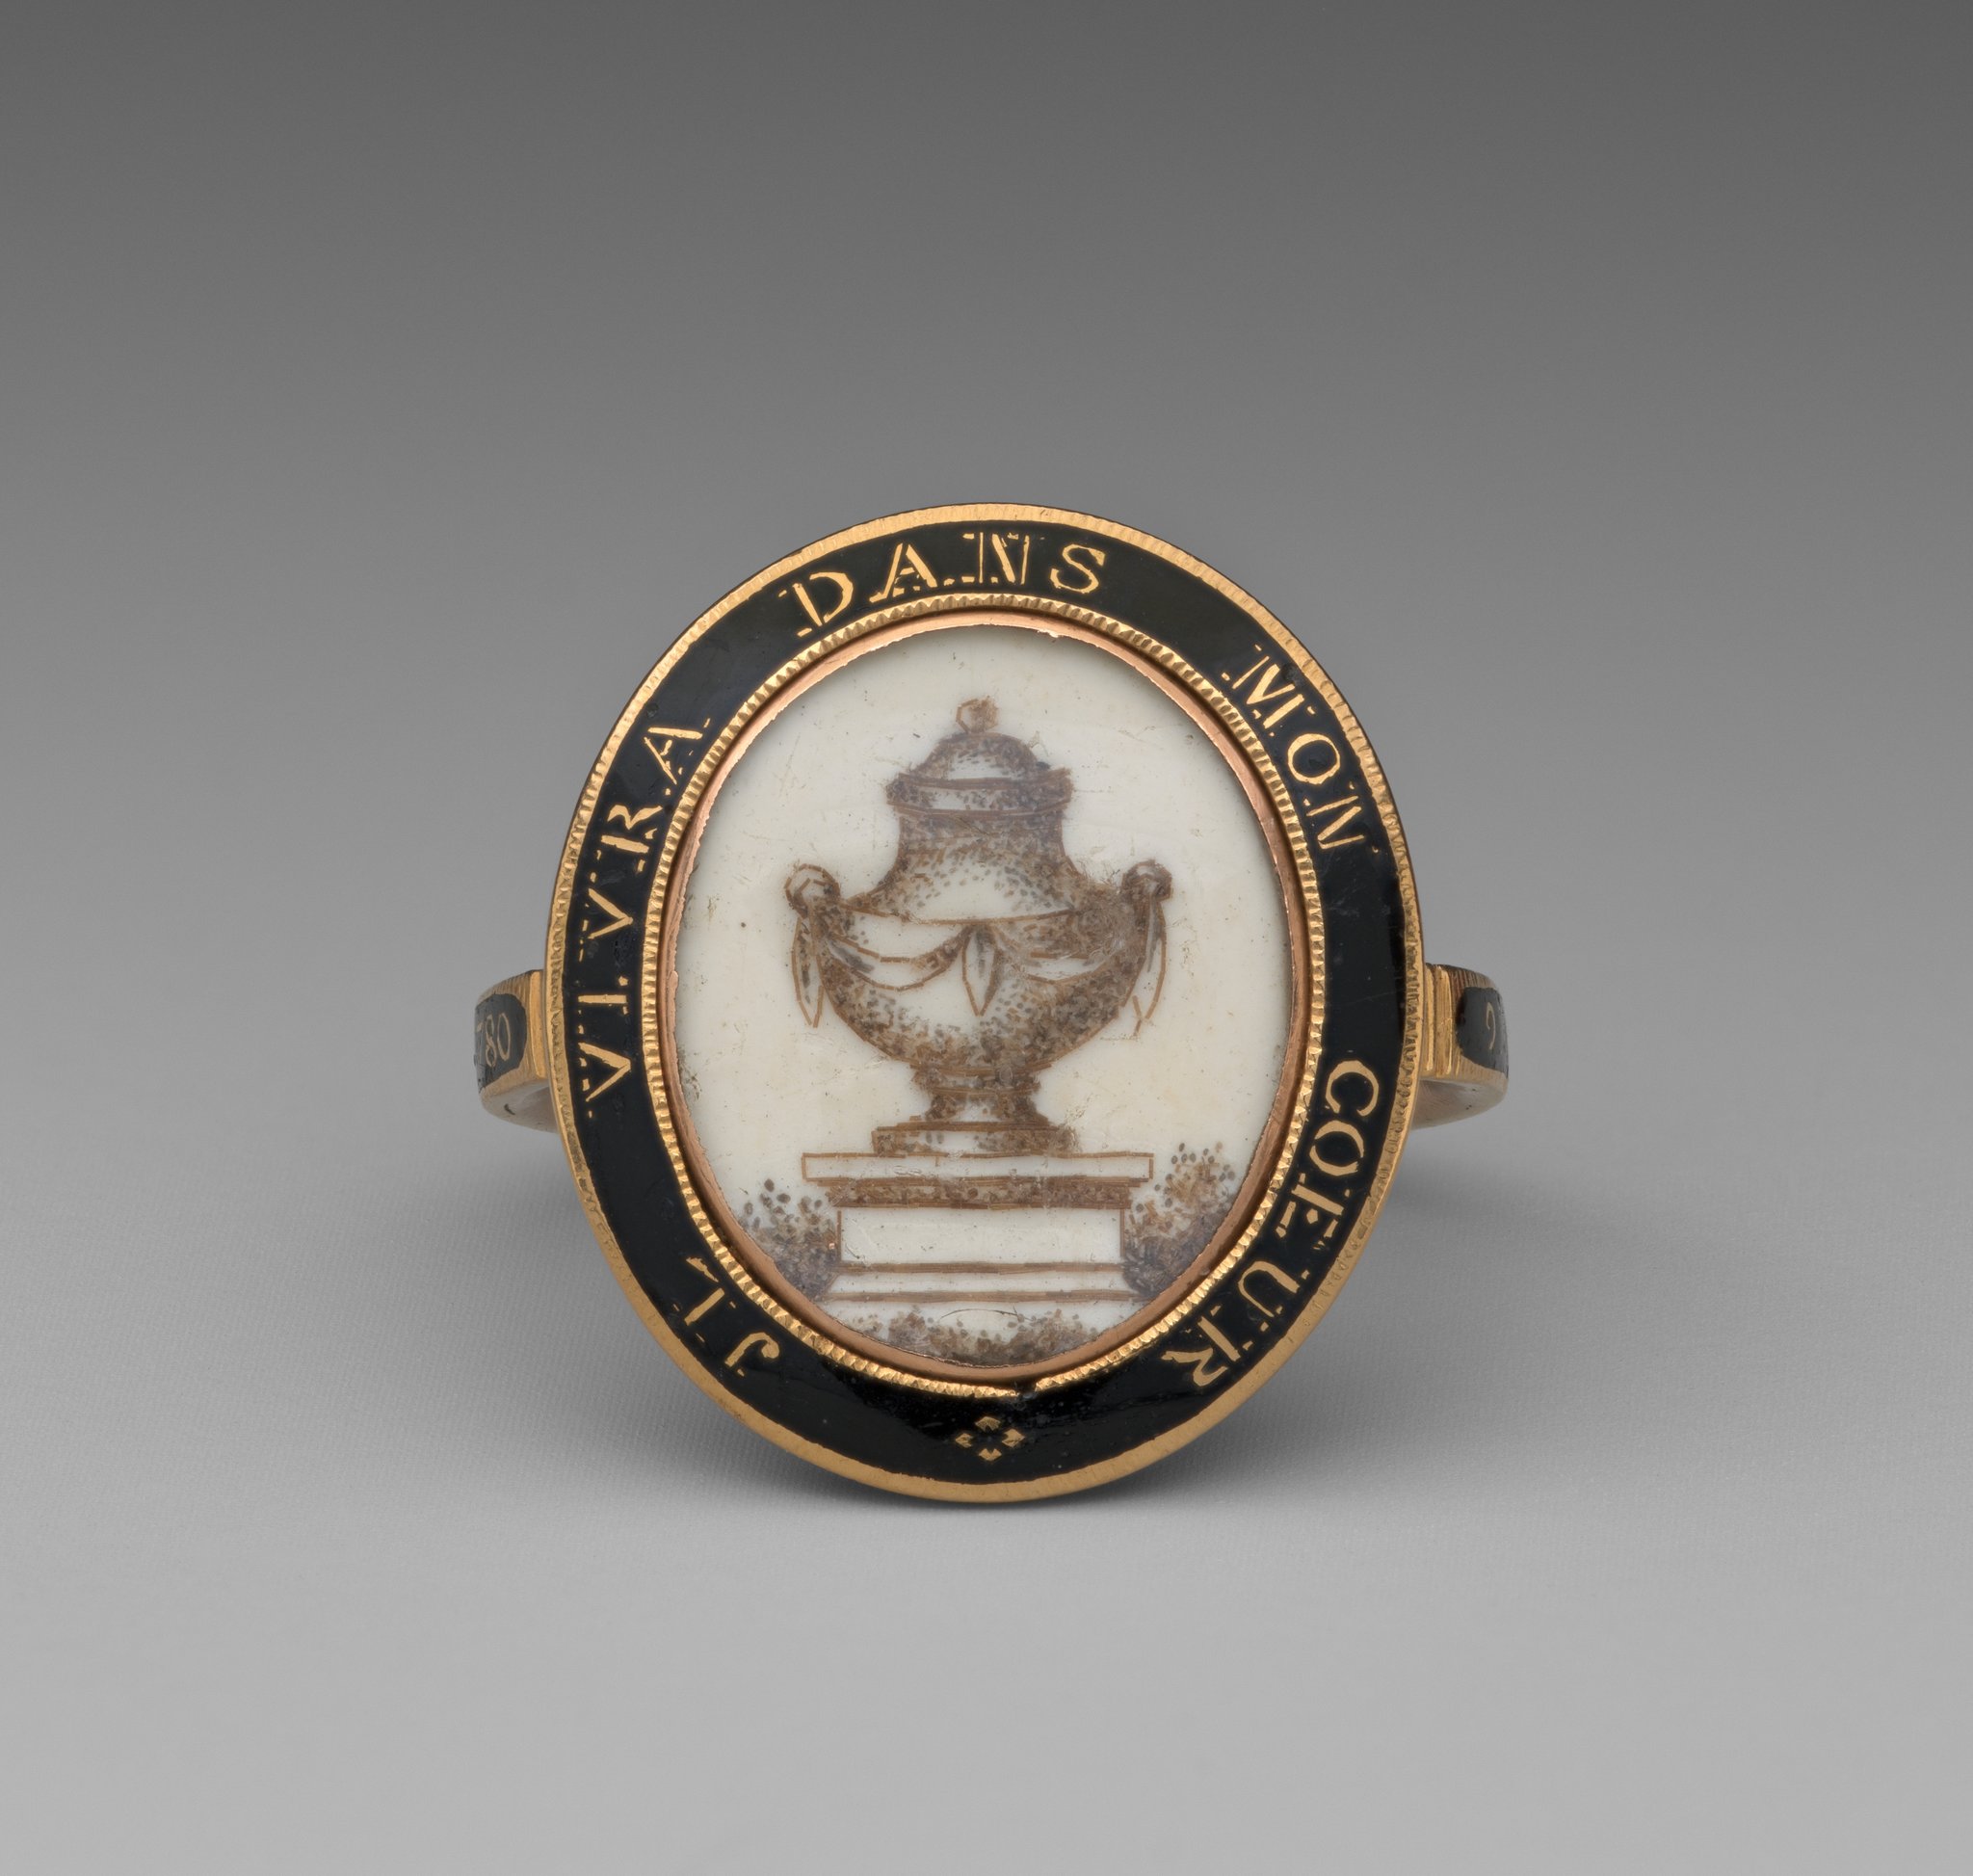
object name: ring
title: Mourning ring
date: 1780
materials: enamel, gold